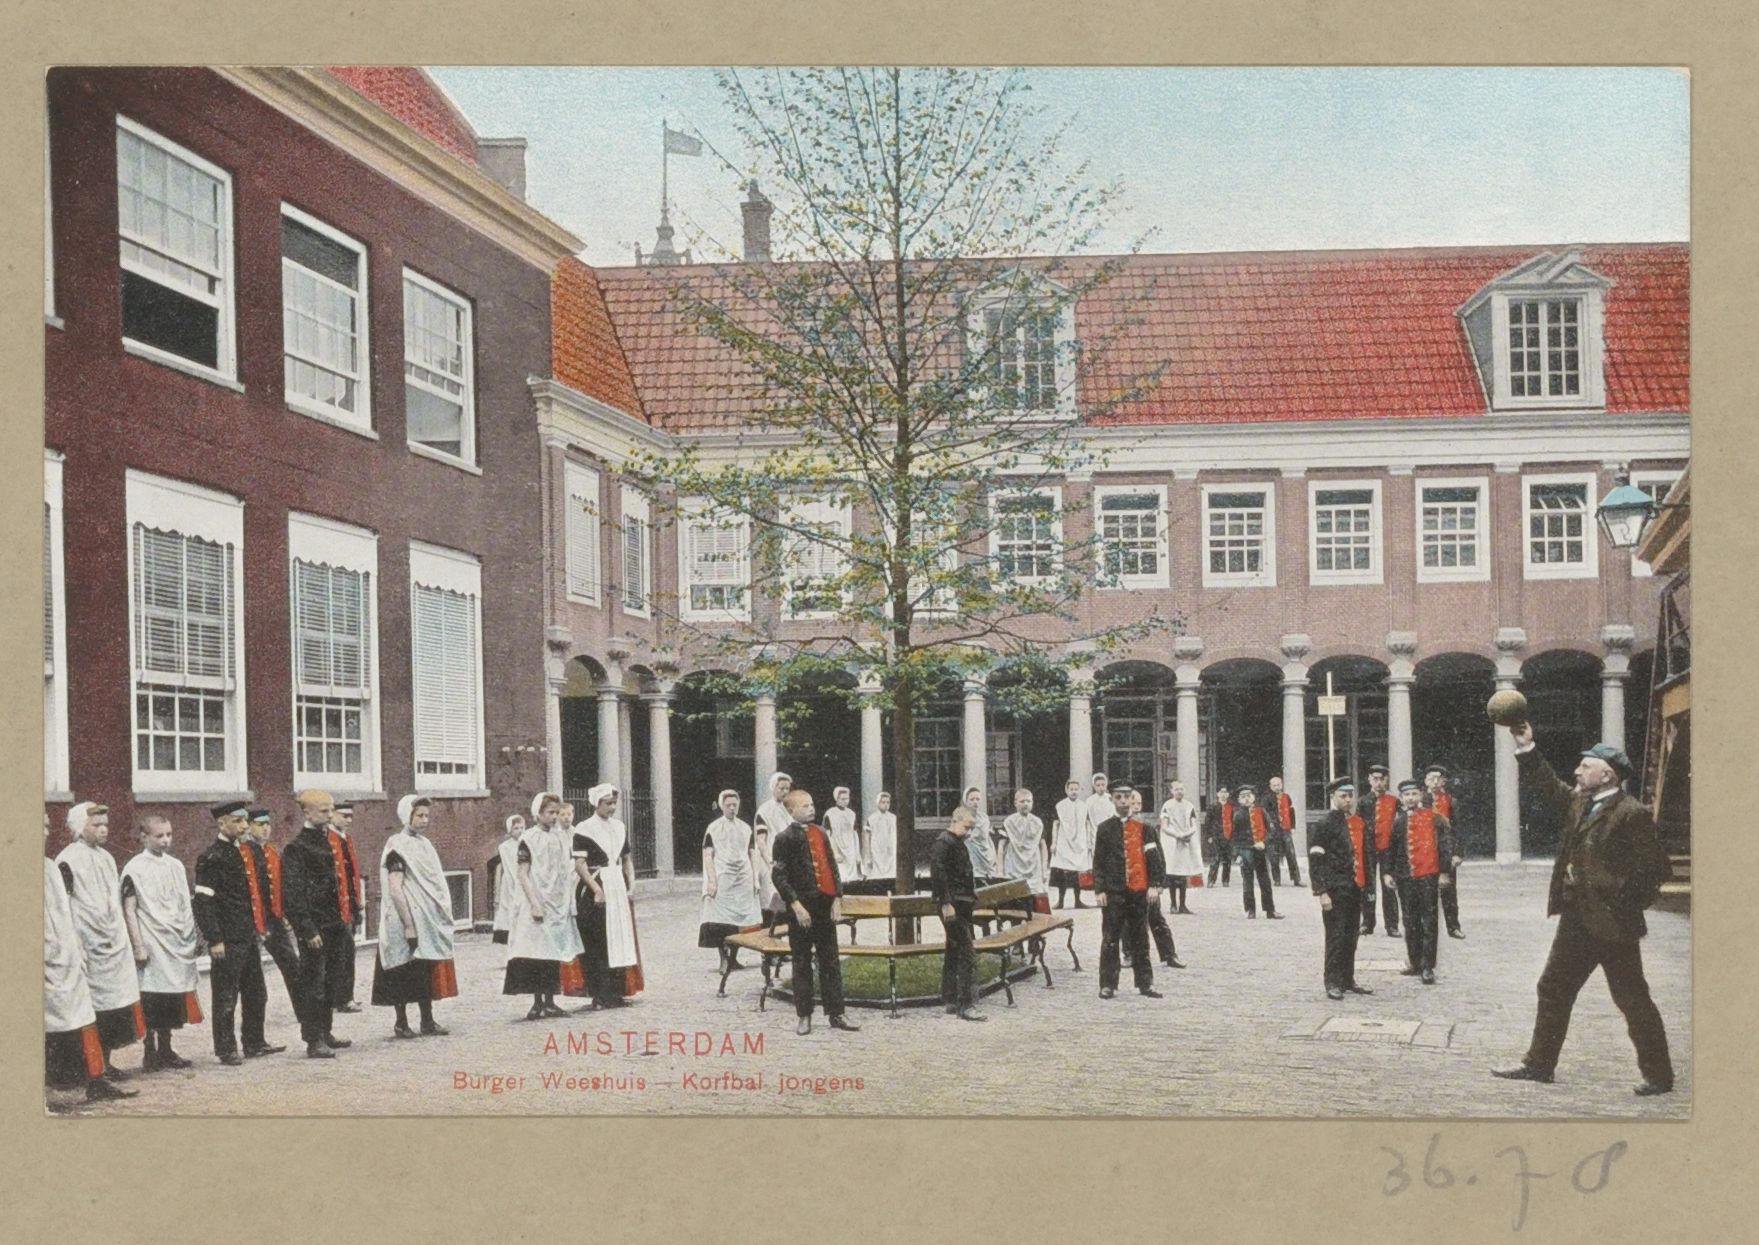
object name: photomechanical print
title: Korfbal op de binnenplaats van het Burgerweeshuis te Amsterdam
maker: Anonymous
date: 1890-1920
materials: cardboard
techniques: four-color autotype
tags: orphanage, orphans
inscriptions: collector's mark: Lugt 1641b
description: Onderwerpsrubriek binnen de Atlas Amsterdam: Armwezen en liefdadige instellingen: I. Stadsinrichtingen: Burgerweeshuis.